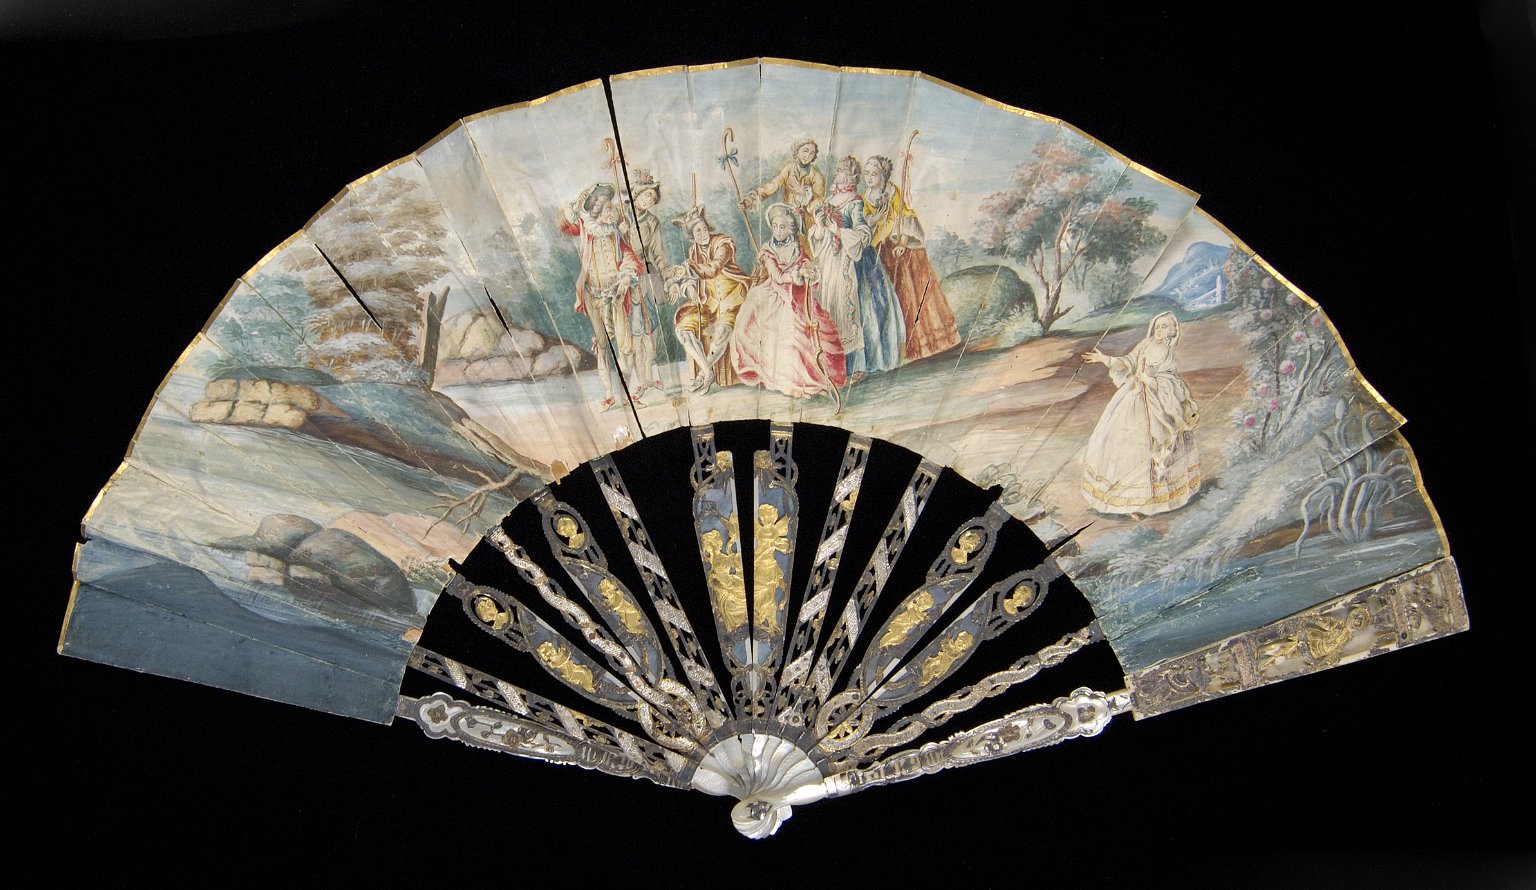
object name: fan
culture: french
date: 1776-1800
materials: mother of pearl, paper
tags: men,women,dogs